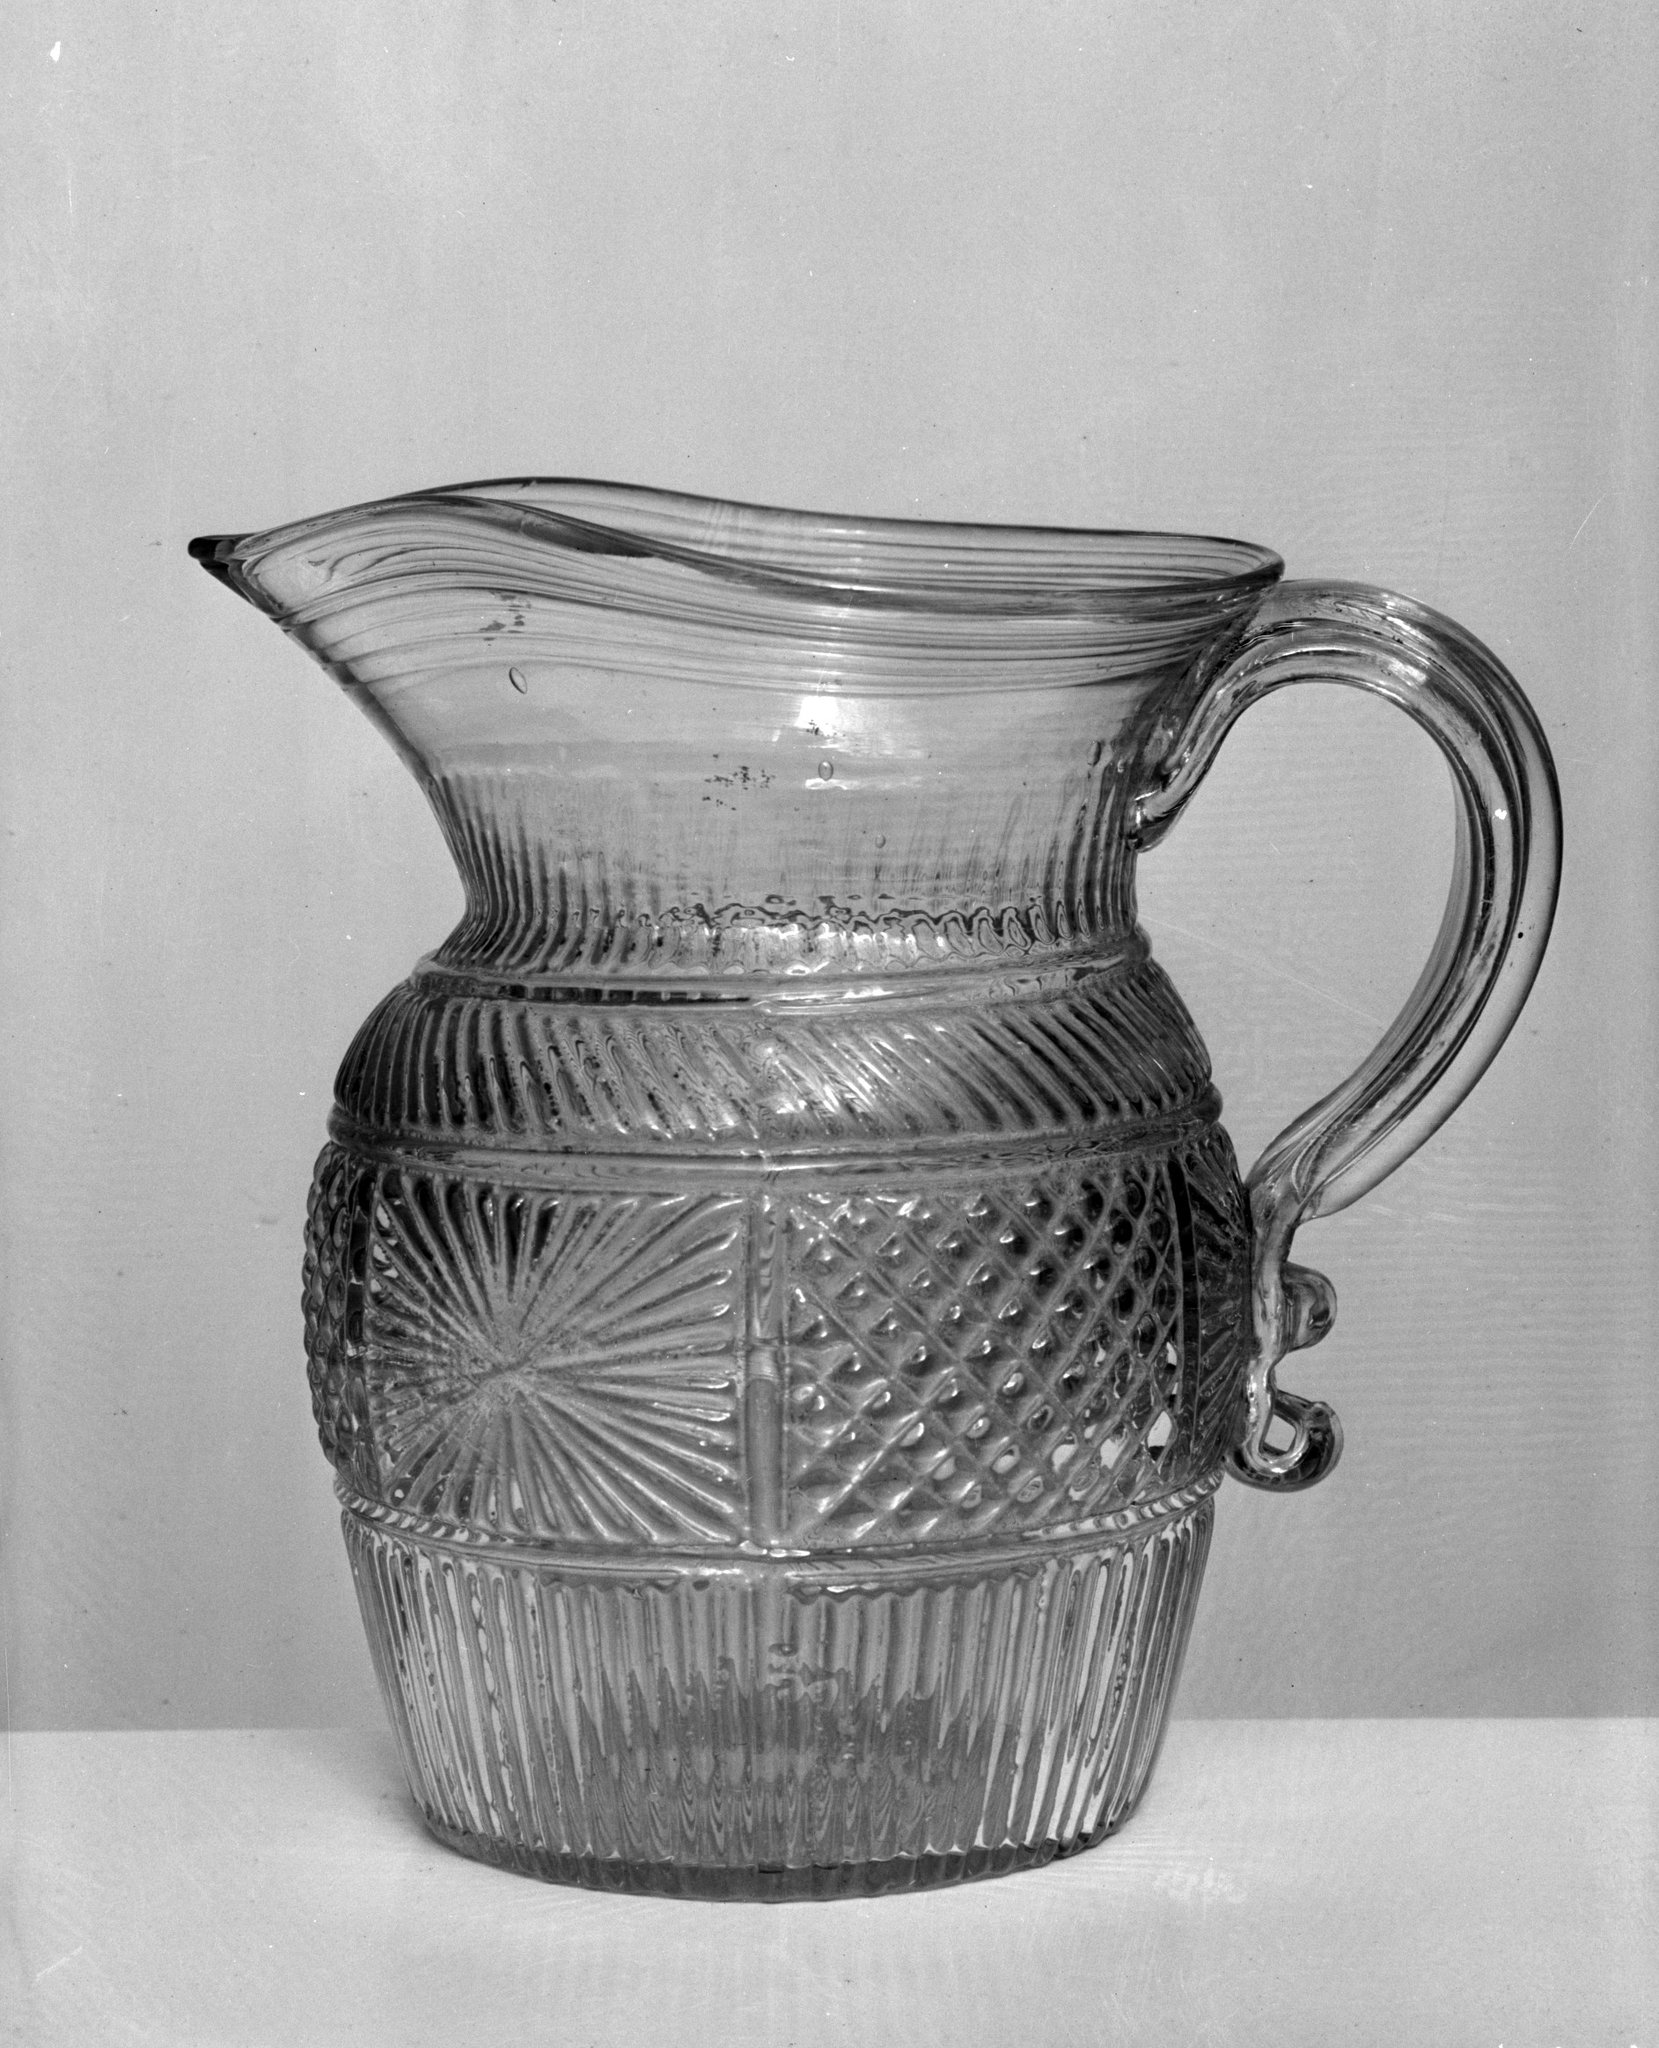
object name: pitcher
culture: american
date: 1820-1840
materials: glass, lead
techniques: glassblowing, molding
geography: united states